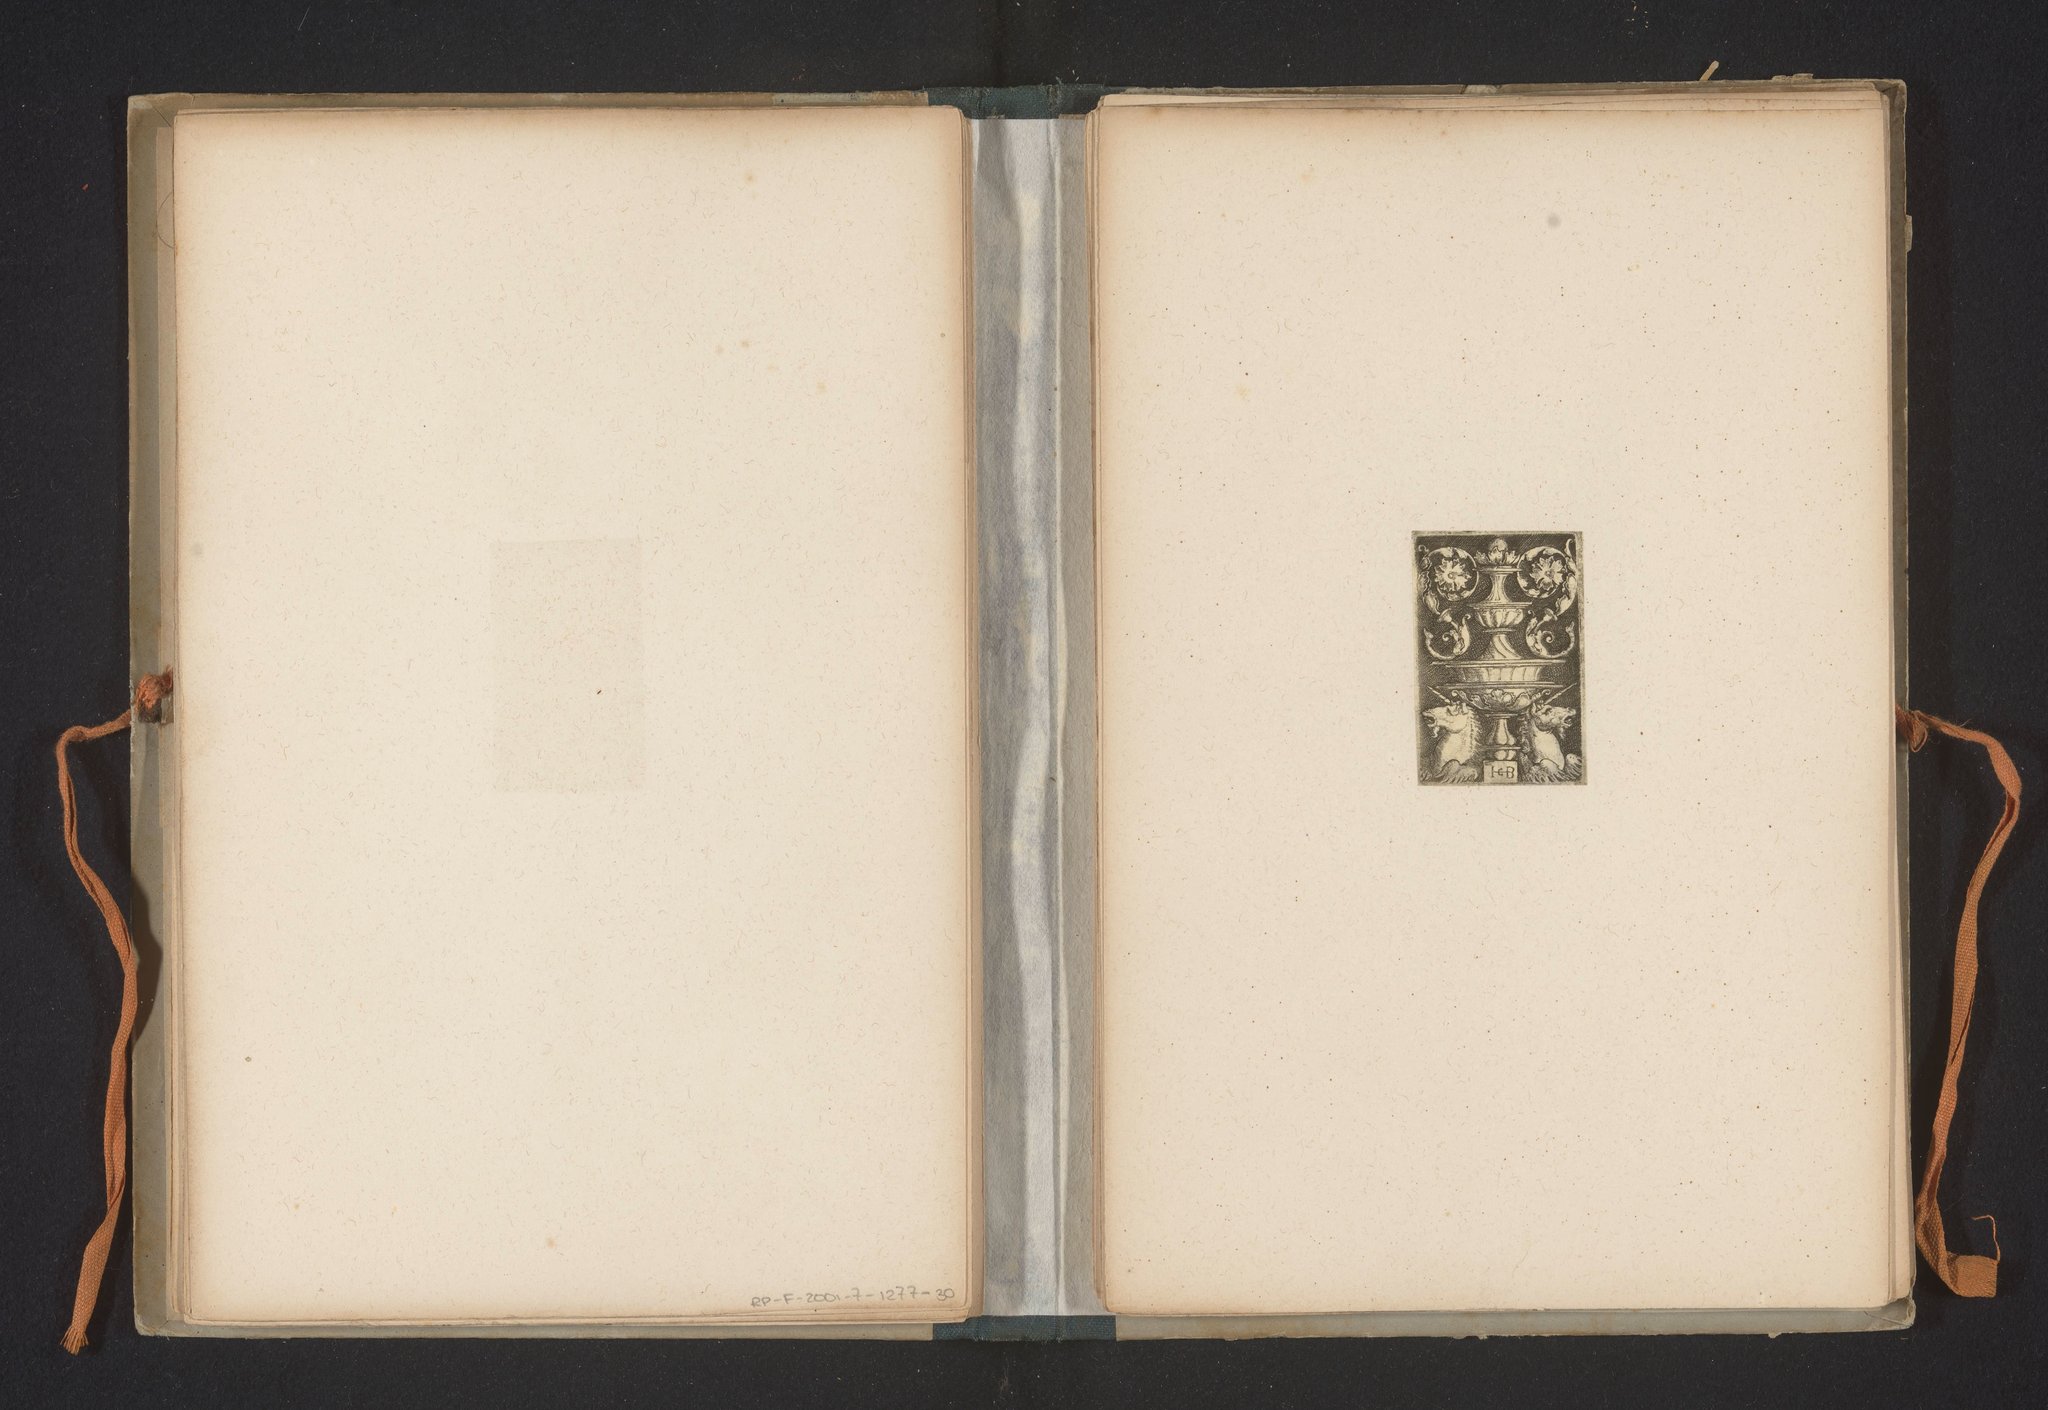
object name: photomechanical print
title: Reproductie van een prent van twee eenhoorns en een vaas door Hans Sebald Beham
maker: hans sebald beham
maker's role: designer, draughtsman, print maker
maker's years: 1500-1550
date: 1866-1871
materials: paper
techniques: woodburytype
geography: brussels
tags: unicorn, vase ~ ornament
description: Deze prent maakt deel uit van een omslag met 57 prenten op 54 bladen.